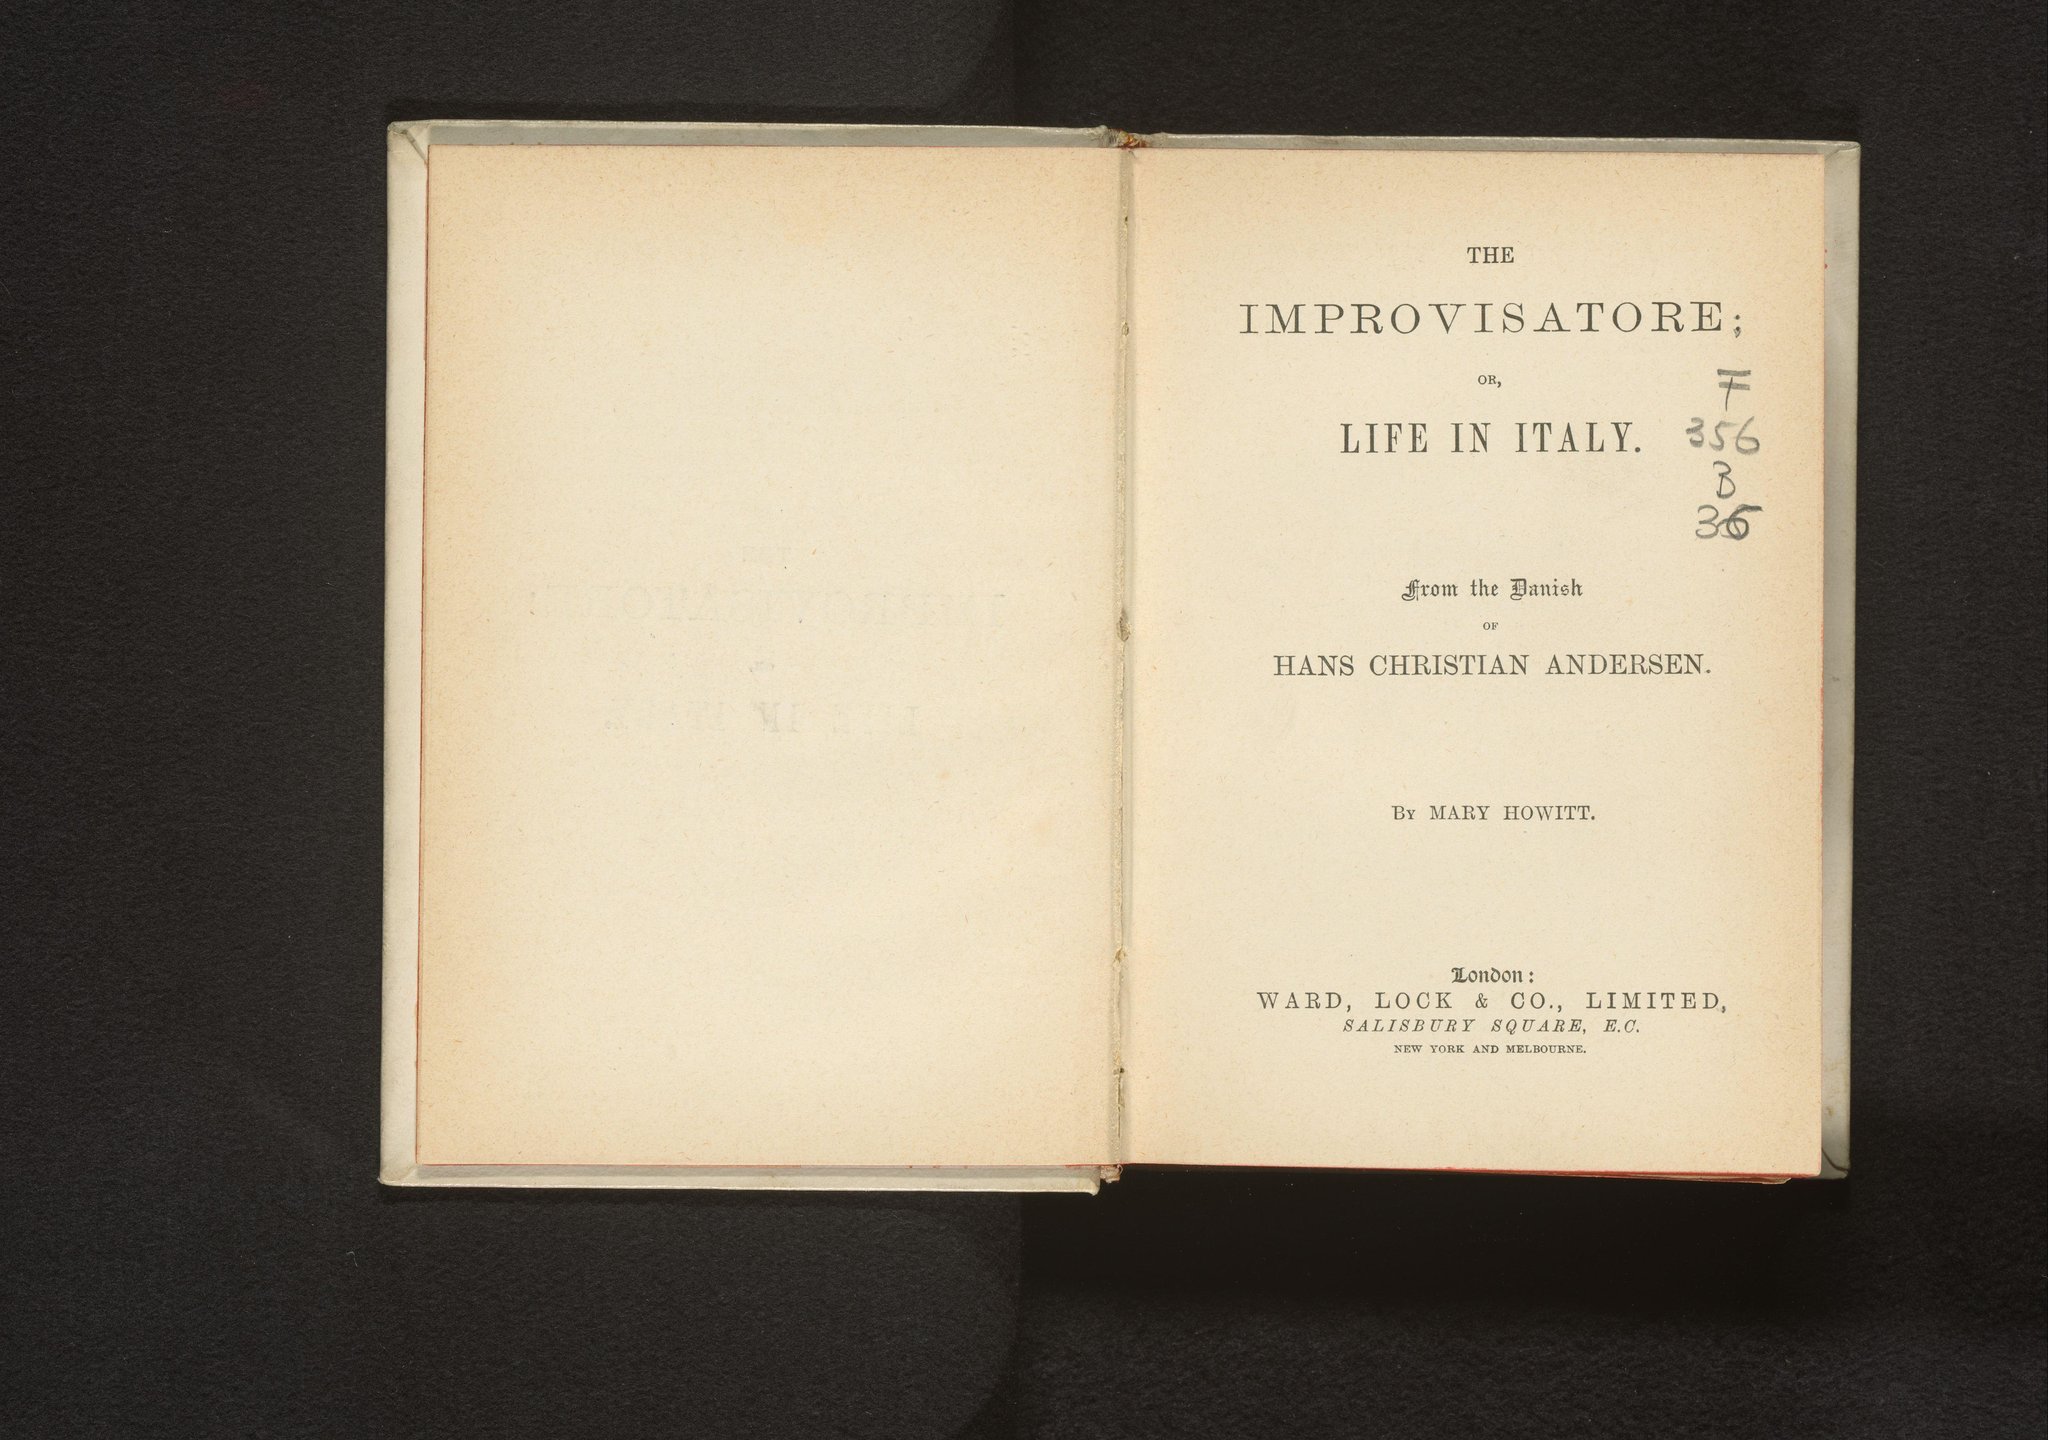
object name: book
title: The improvisatore; or, life in Italy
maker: hans christian andersen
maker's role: schrijver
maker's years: 1805-1875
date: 1880-1900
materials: cardboard, paper, photographic support, parchment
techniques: combed marbled paper, gelatin silver print, printing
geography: london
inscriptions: inscription: ‘ex libris SFJ’